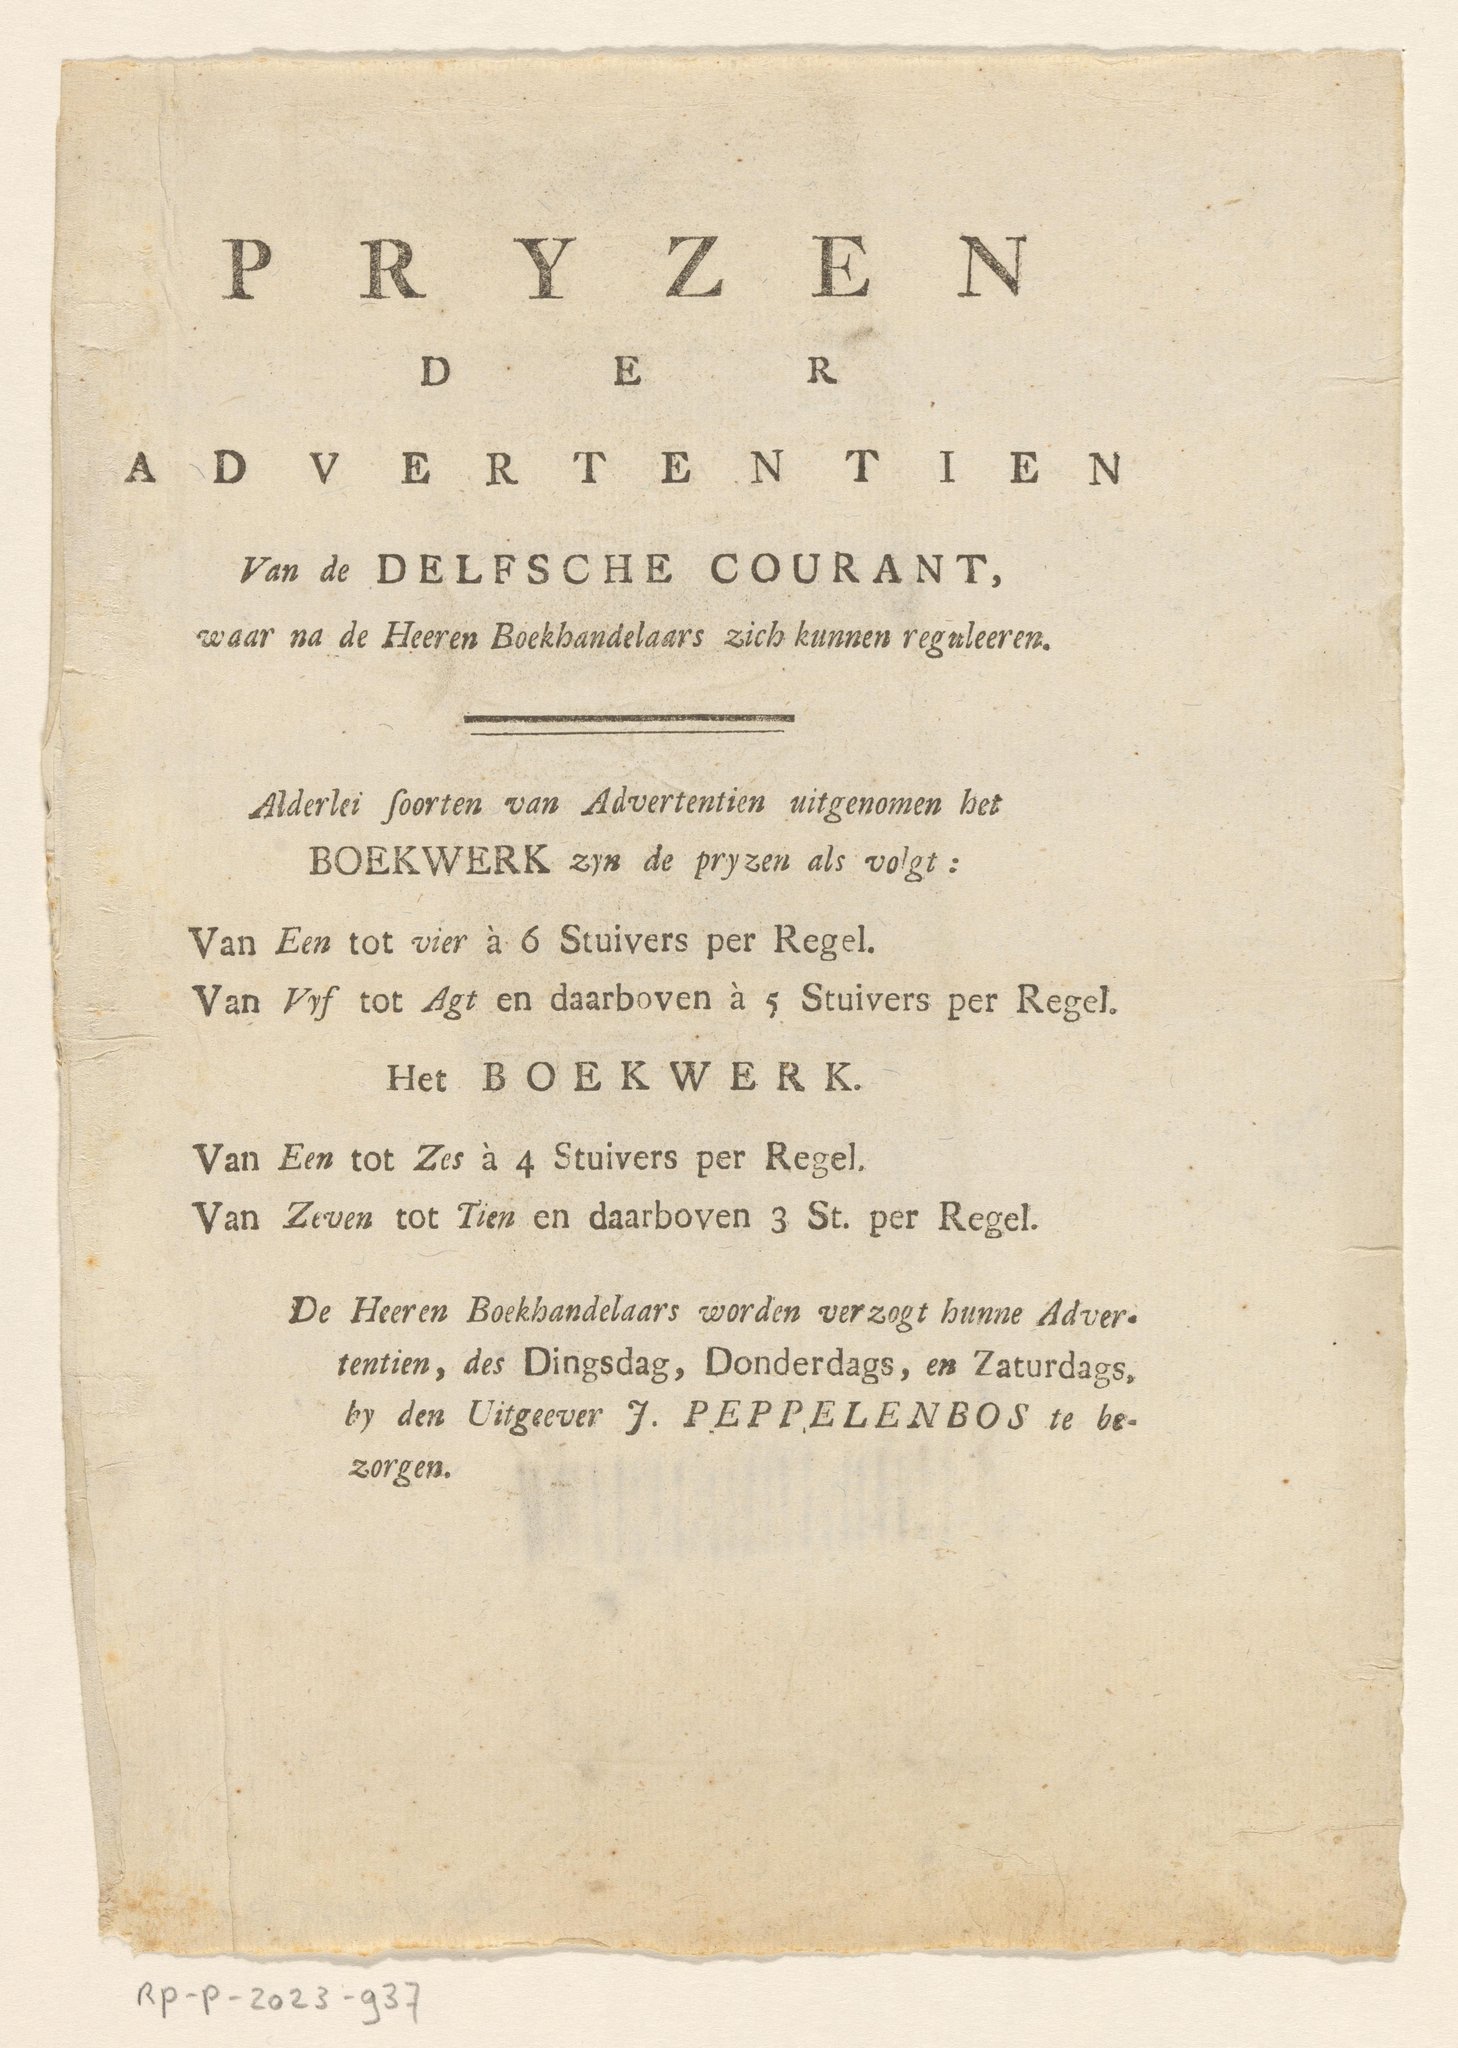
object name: text sheet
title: Pryzen der Advertentien van de Delfsche Courant, waar na de heeren Boekhandelaars zich kunnen reguleeren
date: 1788-1793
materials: paper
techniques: letterpress printing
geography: amsterdam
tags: advertisement, notice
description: Prijslijst van hoeveel boekhandelaren per regel tekst moeten betalen om te adverteren in de Delfsche Courant.